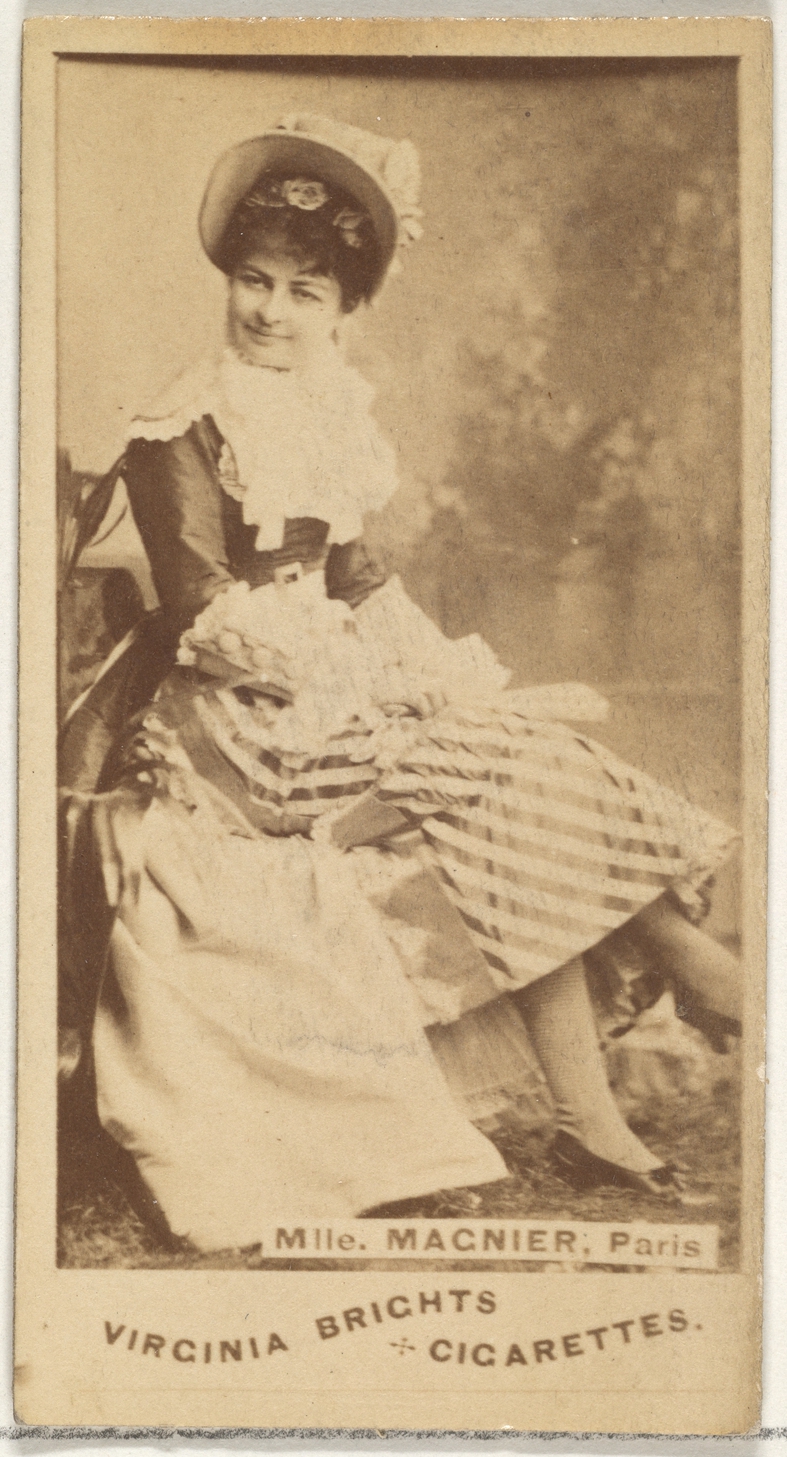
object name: photograph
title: Mlle. Magnier, Paris, from the Actors and Actresses series (N45, Type 1) for Virginia Brights Cigarettes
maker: allen & ginter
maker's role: publisher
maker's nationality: american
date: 1888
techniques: albumen silver print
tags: portraits,women,actresses